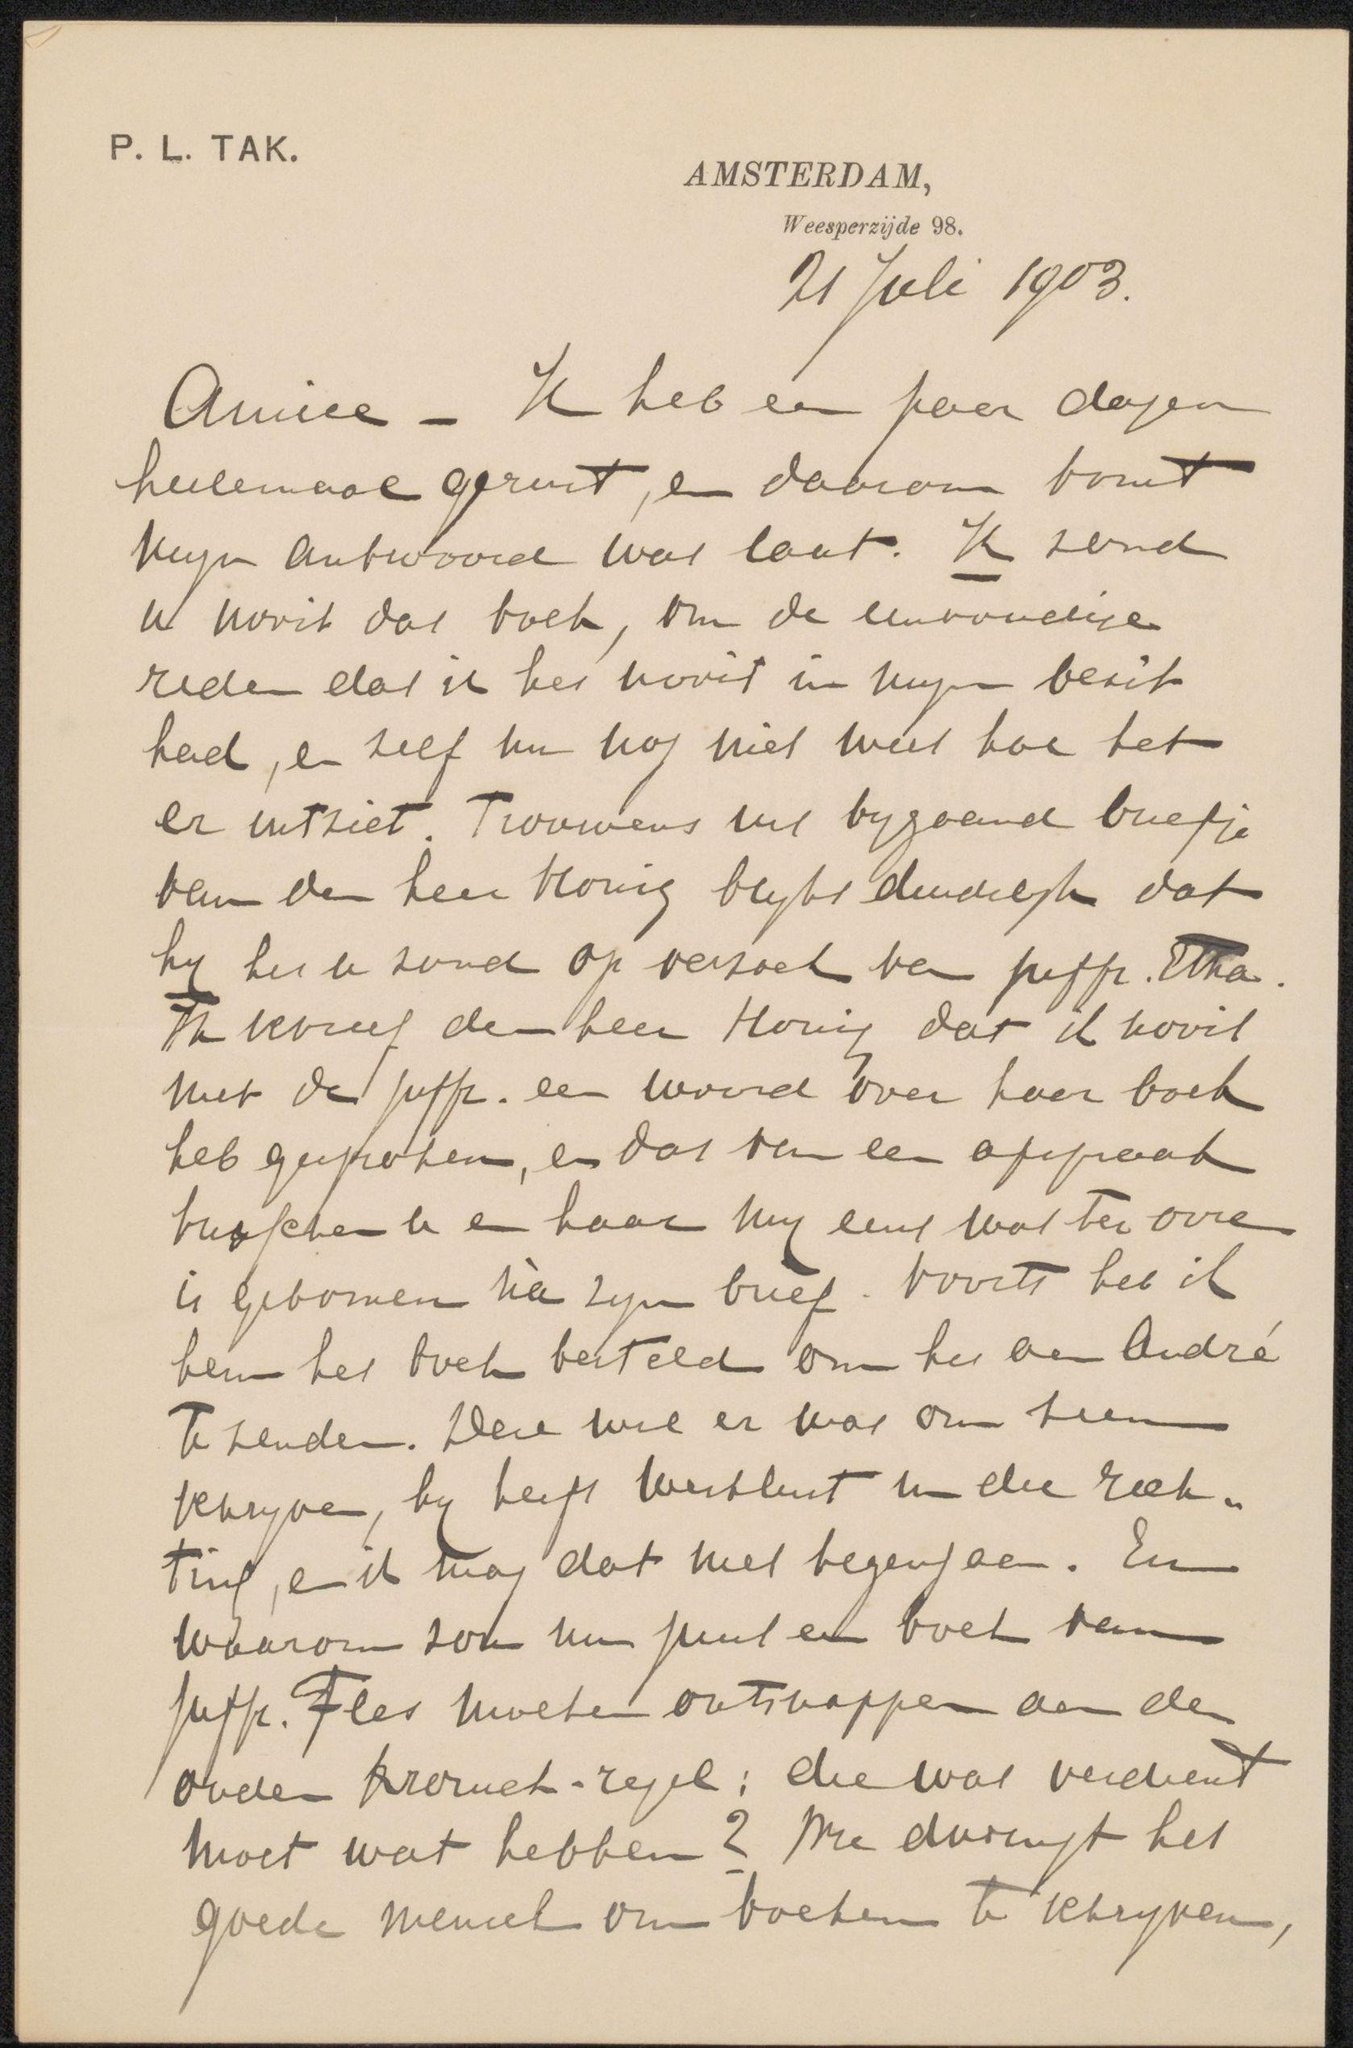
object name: letter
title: Brief aan Jan Veth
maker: pieter lodewijk tak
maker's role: politician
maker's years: 1848-1907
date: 1903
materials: ink, paper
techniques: pen, printing, writing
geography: amsterdam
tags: dordrecht, amsterdam, painter, print maker, draughtsman, designer, jan veth, etha fles, leiden, utrecht, willem vogelsang, andré jolles, printed matter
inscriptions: watermark, collector's mark: ‘RPK’